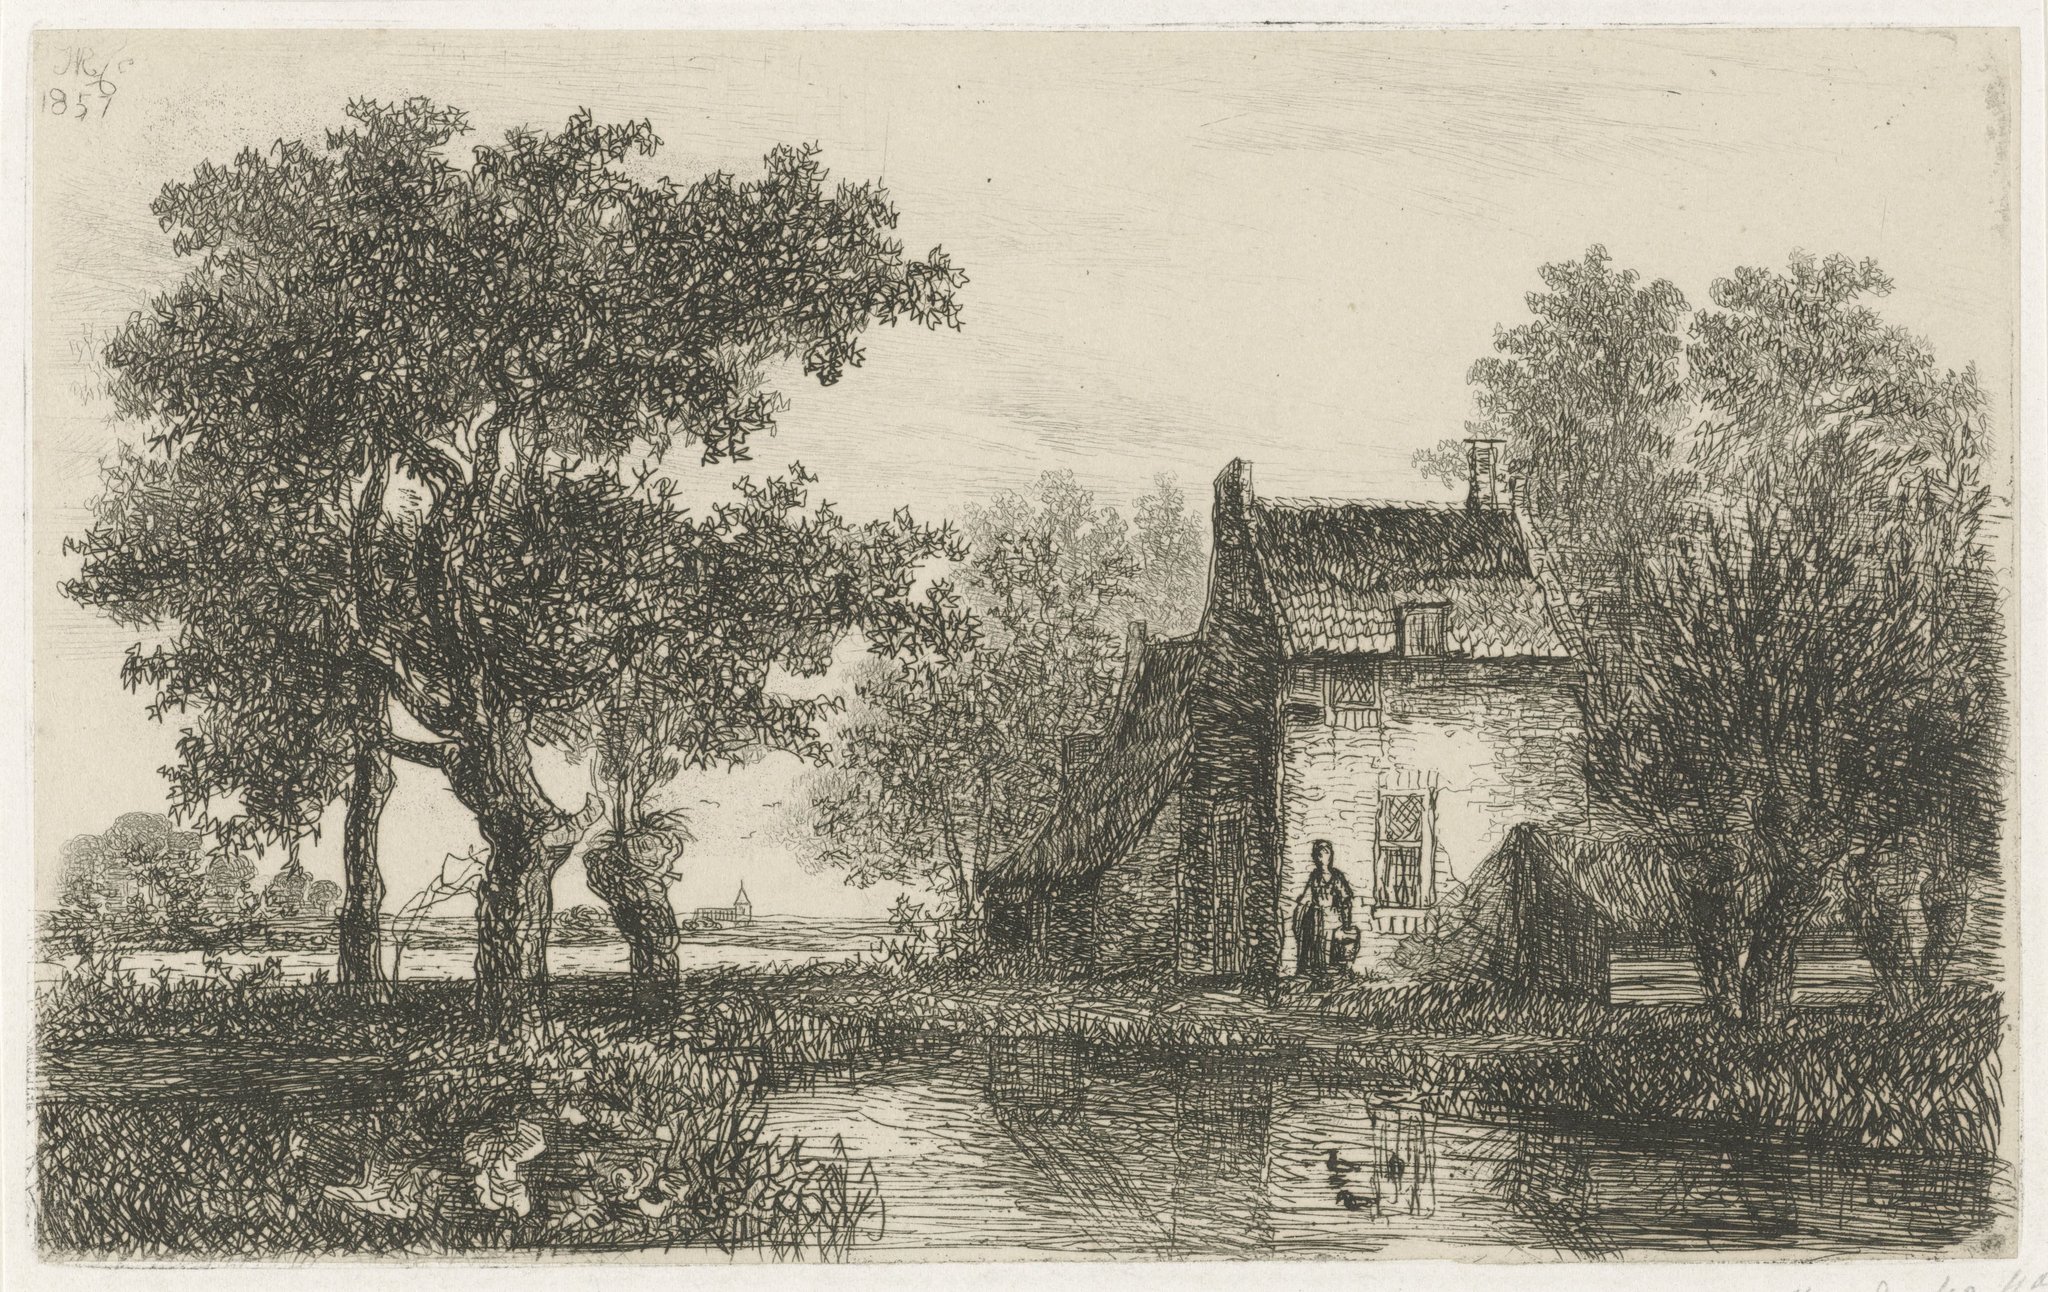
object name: print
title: Vrouw met een mand voor een boerenhuis aan het water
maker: hermanus jan hendrik van rijkelijkhuysen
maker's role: painter, print maker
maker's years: 1813-1883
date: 1857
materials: paper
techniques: drypoint, etching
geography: utrecht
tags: trees, small canal, ditch, farm or solitary house in landscape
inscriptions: collector's mark: Lugt 2228